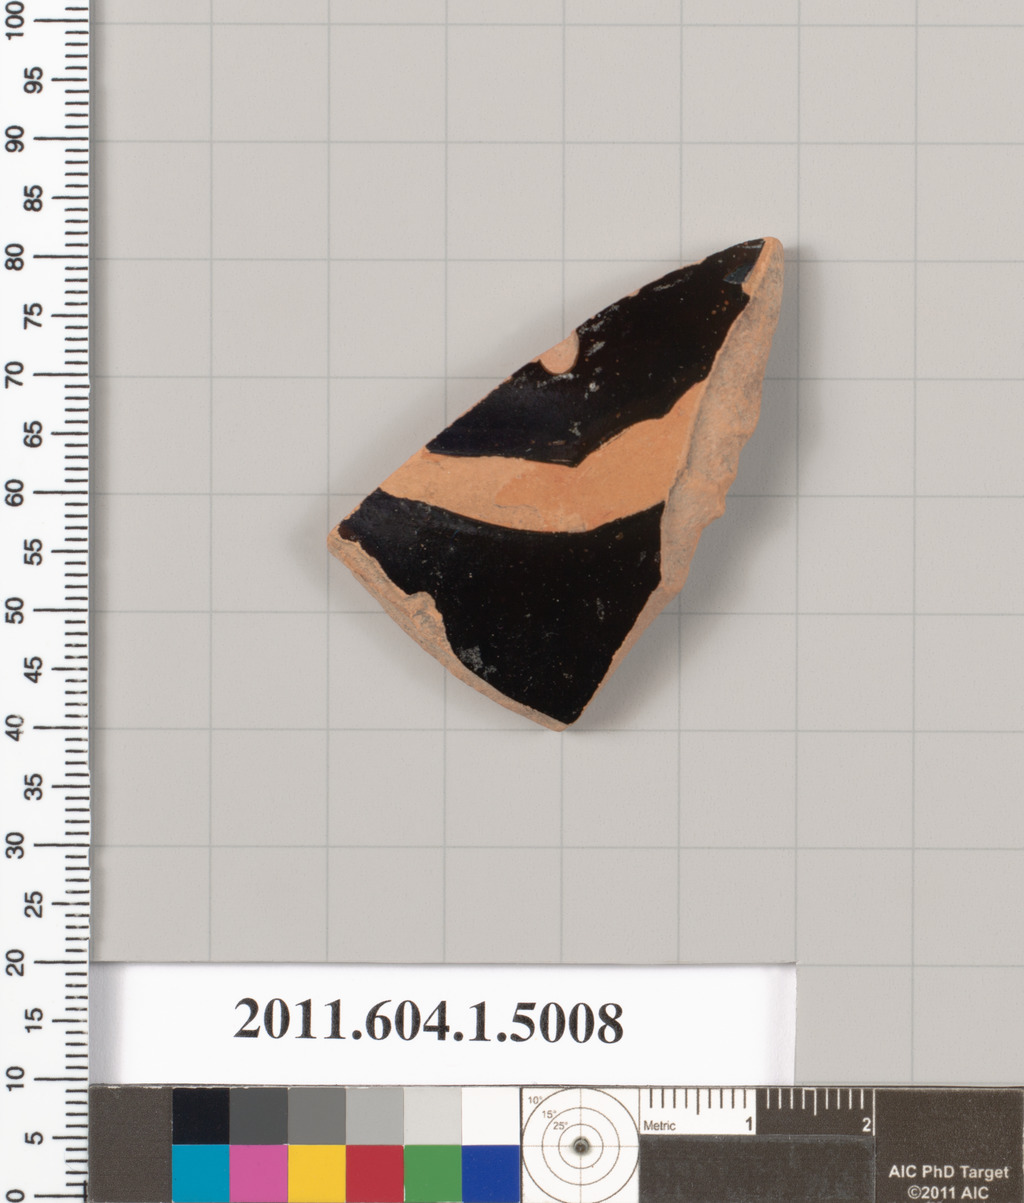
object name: kylix fragment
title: Terracotta fragment of a kylix (drinking cup)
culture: greek, attic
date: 490-480 BCE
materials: terracotta